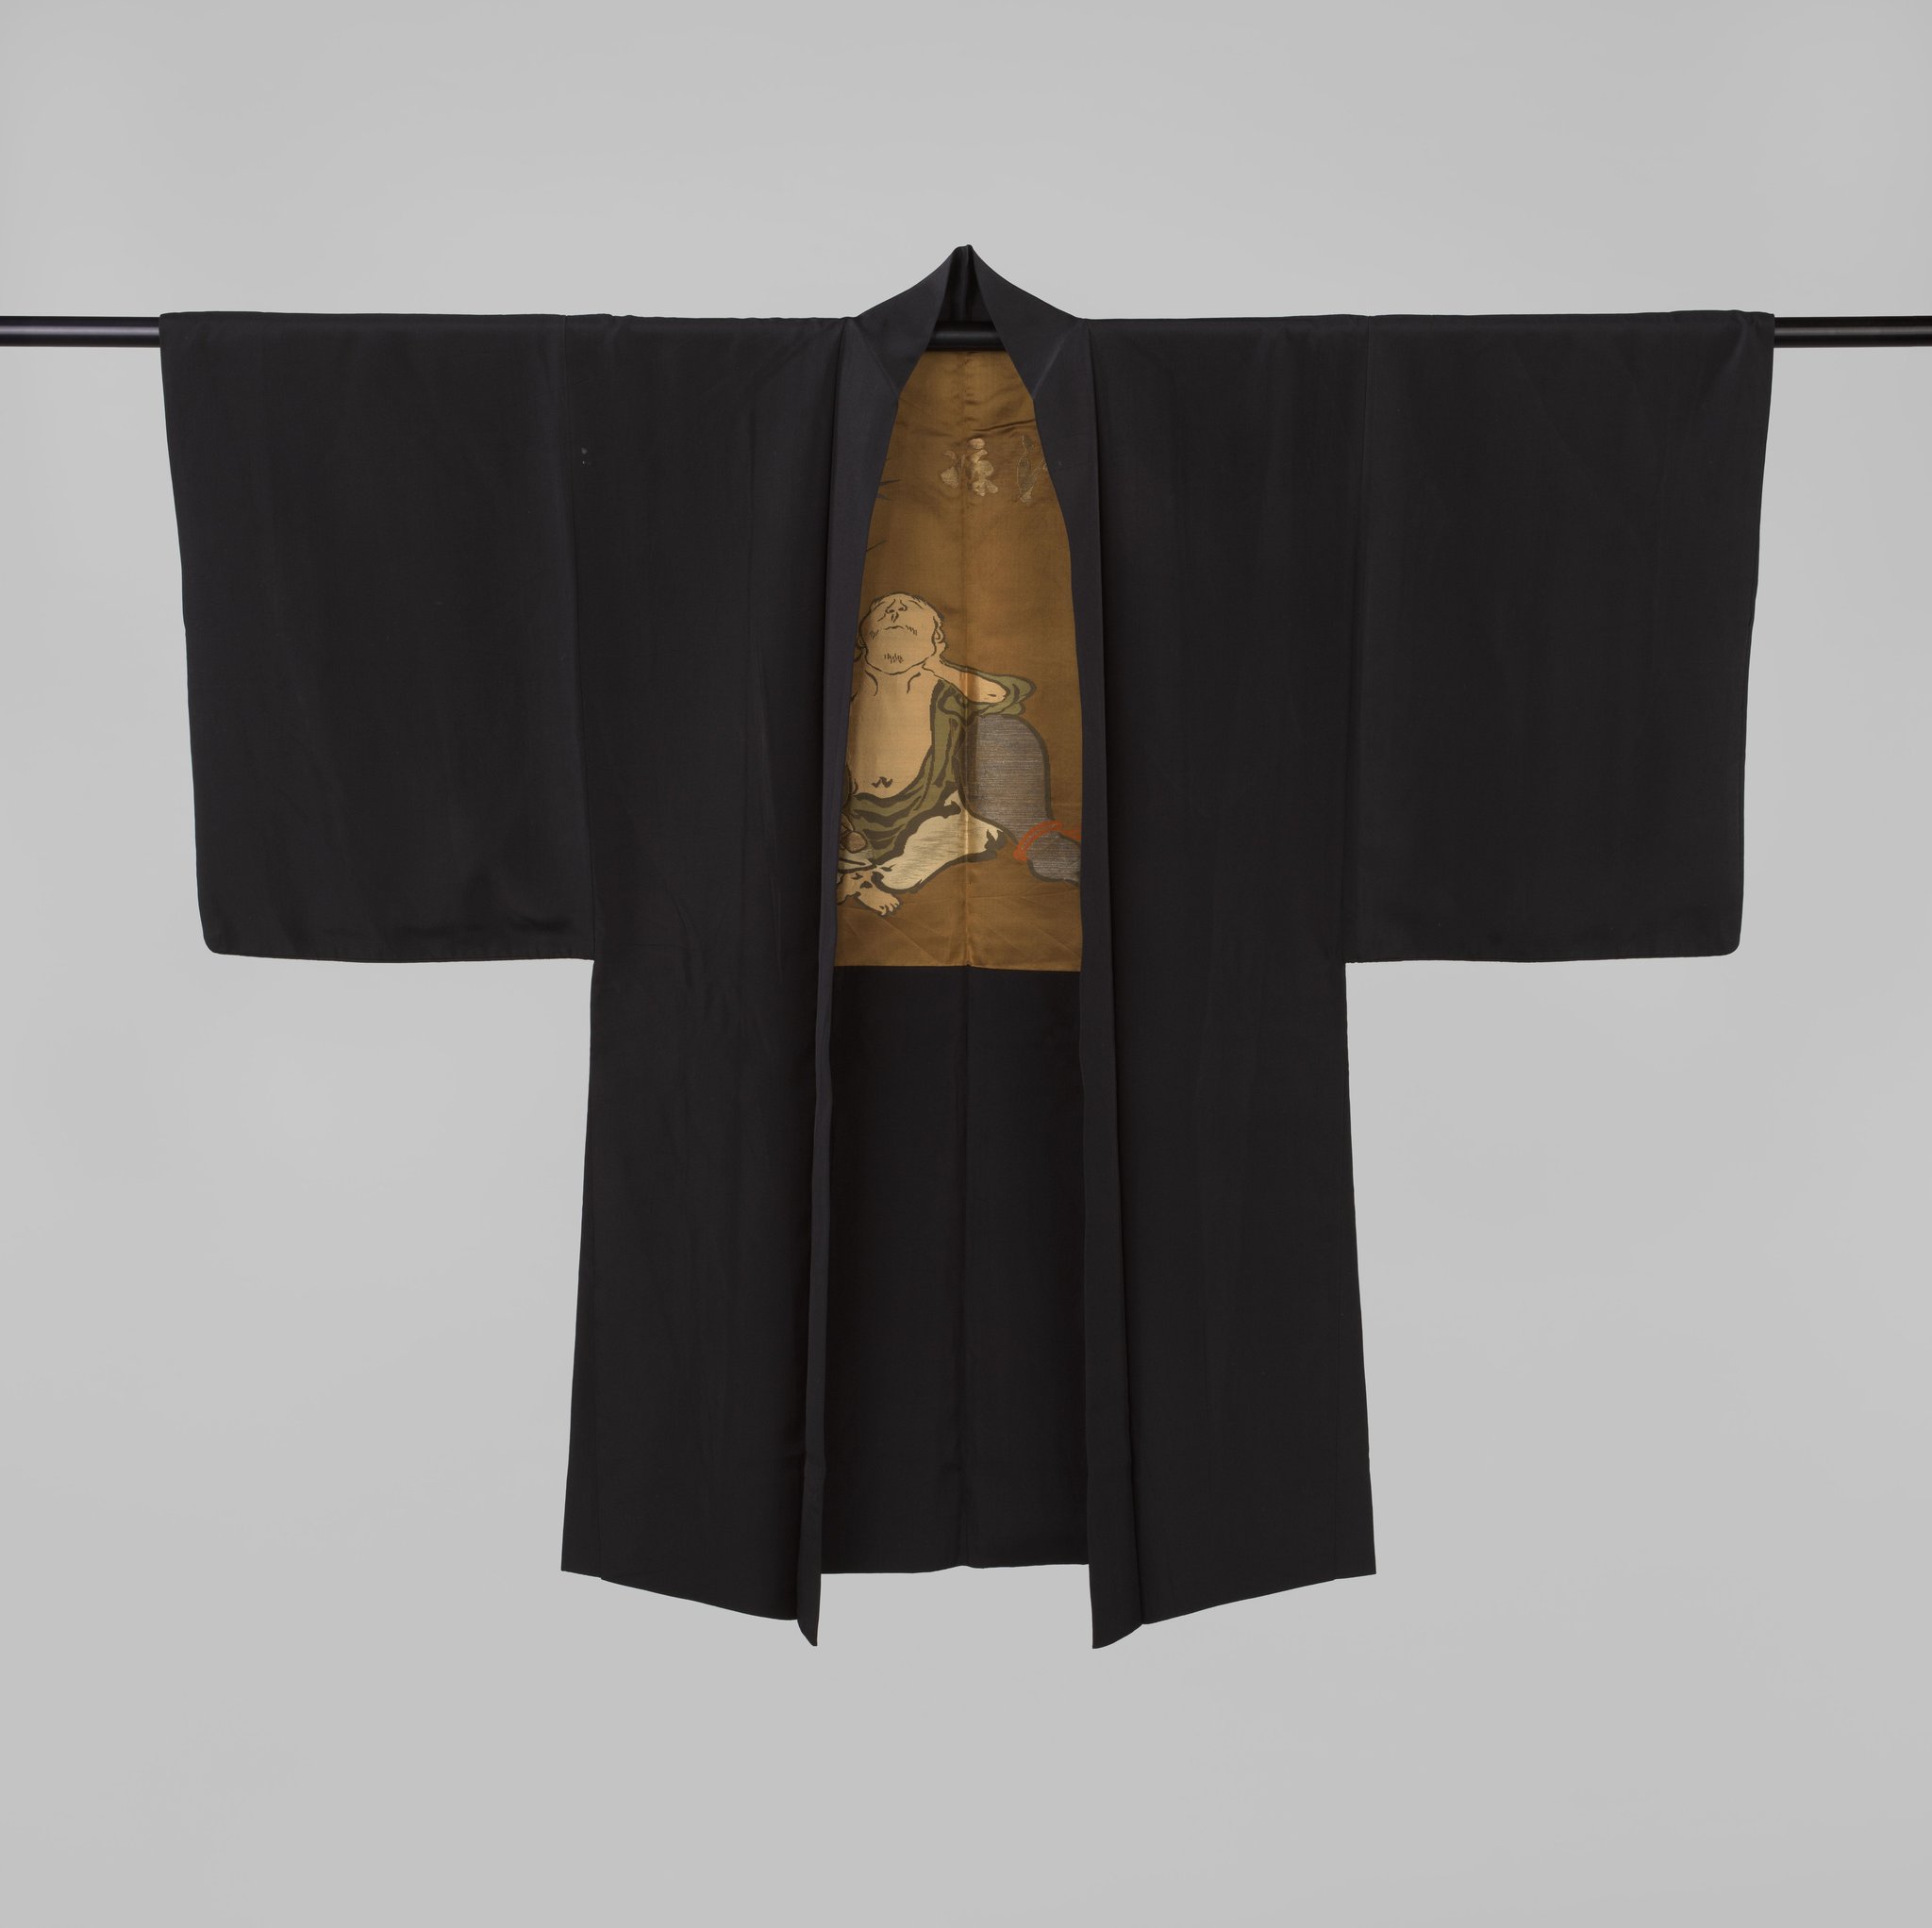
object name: kimono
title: Haori voor mannen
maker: Anonymous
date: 1920-1940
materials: silk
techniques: weave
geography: japan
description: Kosagi with his sake-gourd. Three crests.